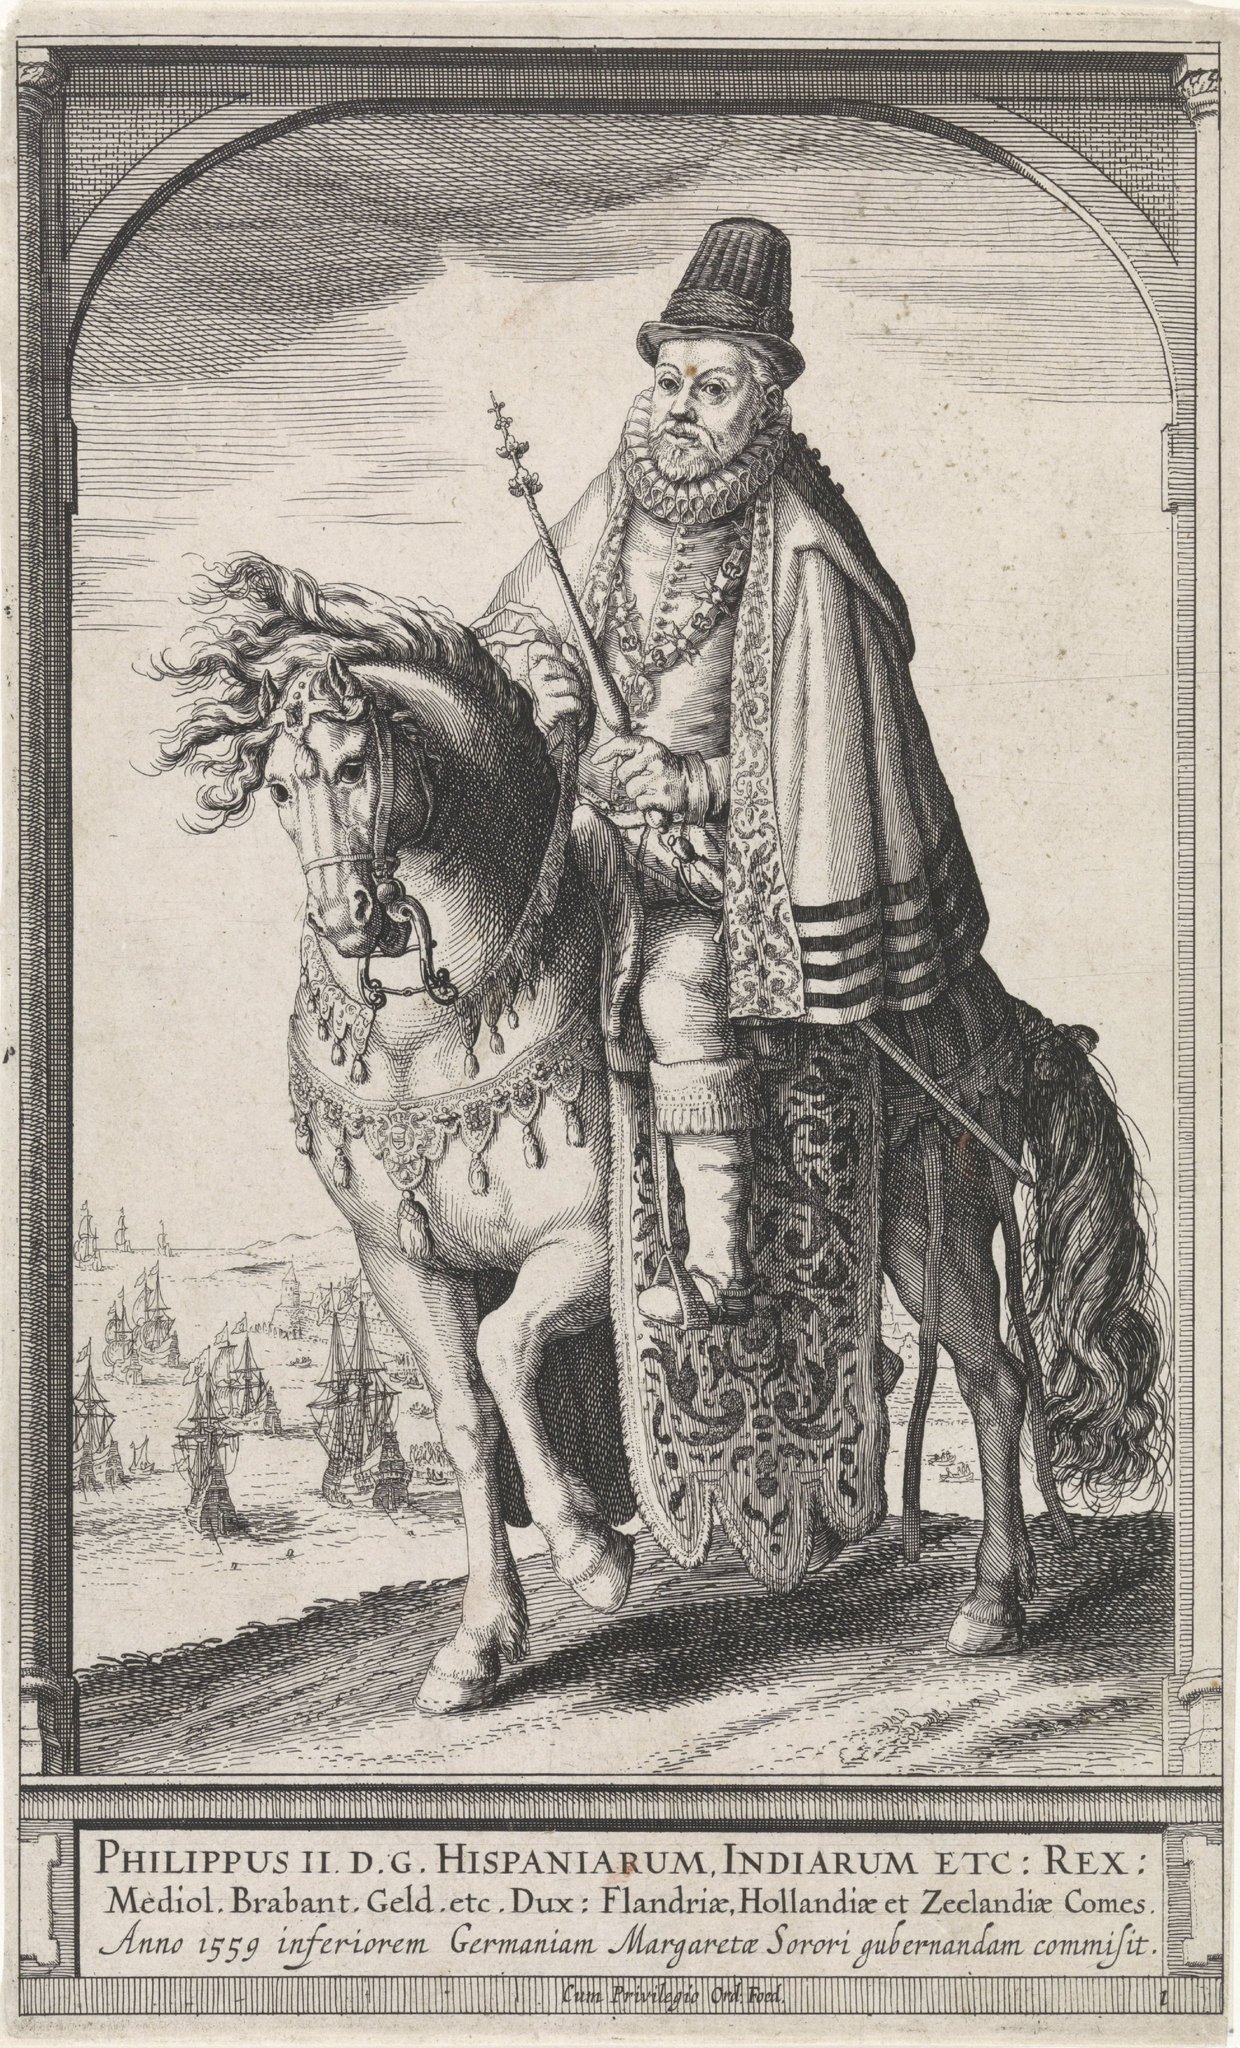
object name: print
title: Ruiterportret van Filips II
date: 1591-1632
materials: paper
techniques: etching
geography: amsterdam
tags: philip ii of spain, riding a horse, ass, or mule; rider, horseman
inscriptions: collector's mark: Lugt 2228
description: Filips II, koning van spanje en landsheer van de Nederlanden, te paard. Naar links. Hij heeft een scepter in de hand. Op de achtergrond de Spaanse Armada. De prent heeft een Latijns onderschrift en maakt deel uit van een serie ruiterportretten van Nederlandse landvoogden.